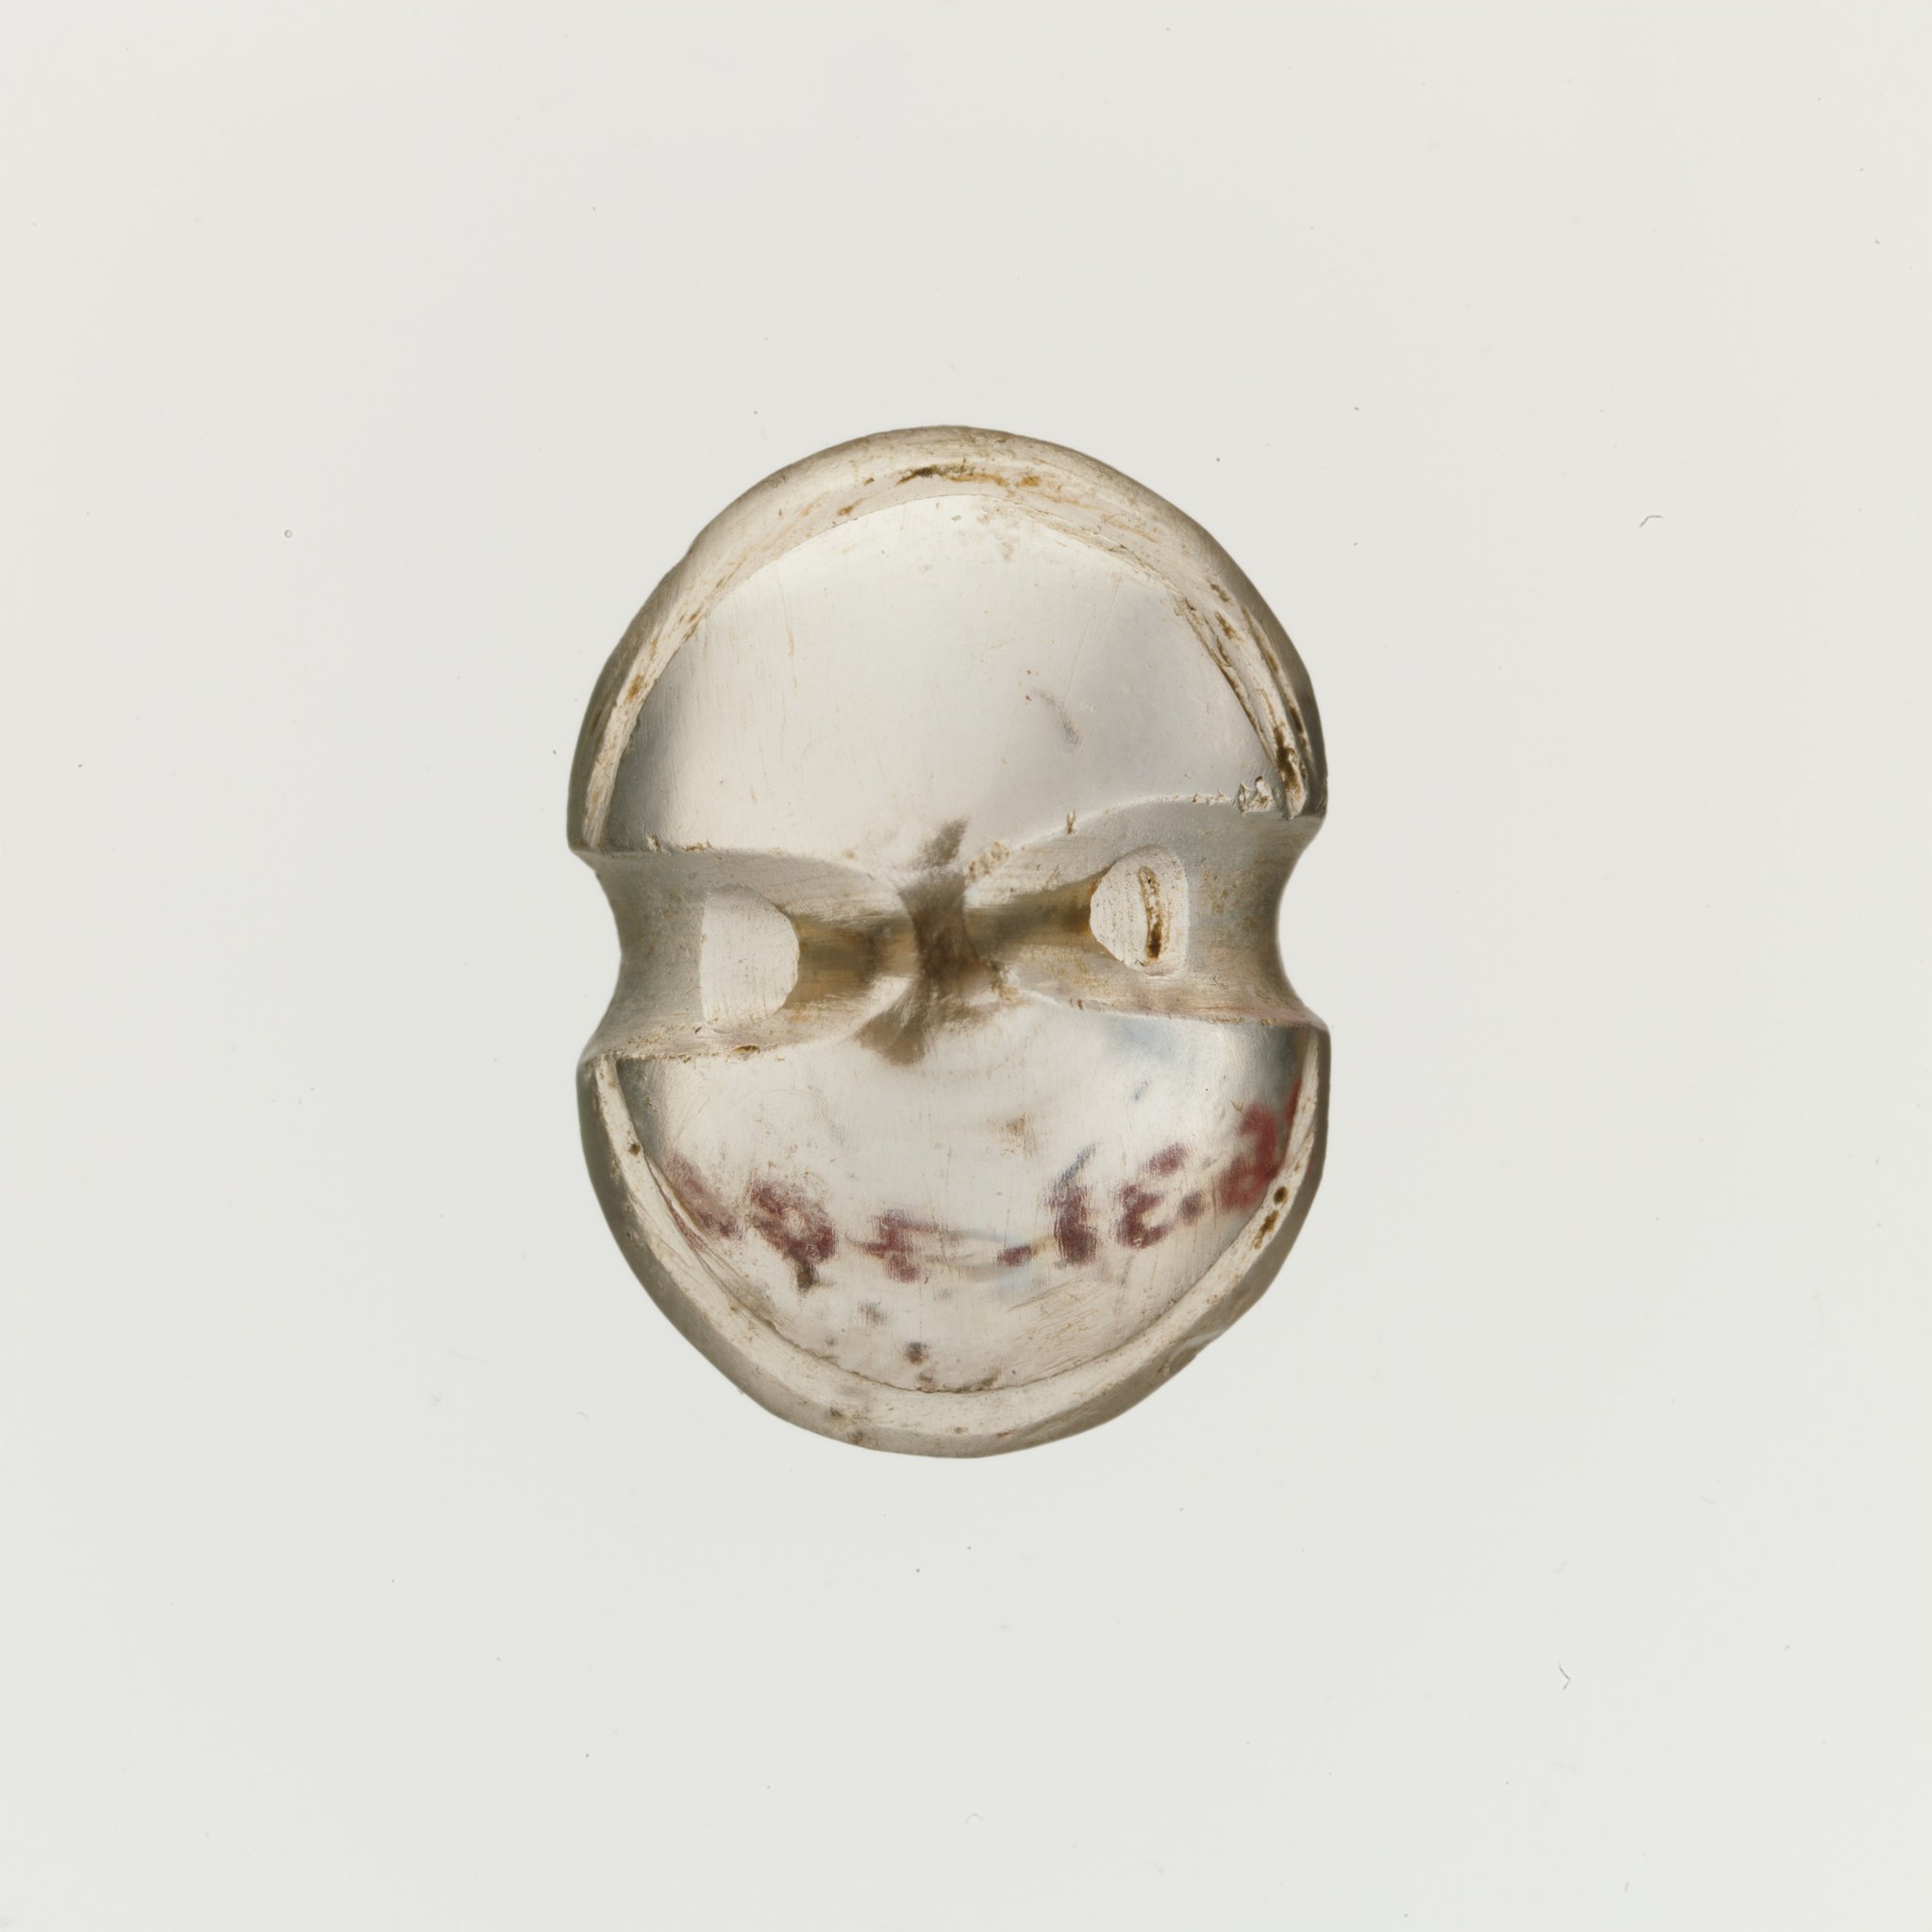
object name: spindle whorl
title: Rock crystal bead in the form of a figure-of-eight shield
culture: minoan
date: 2200-1450 BCE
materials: quartz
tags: shields